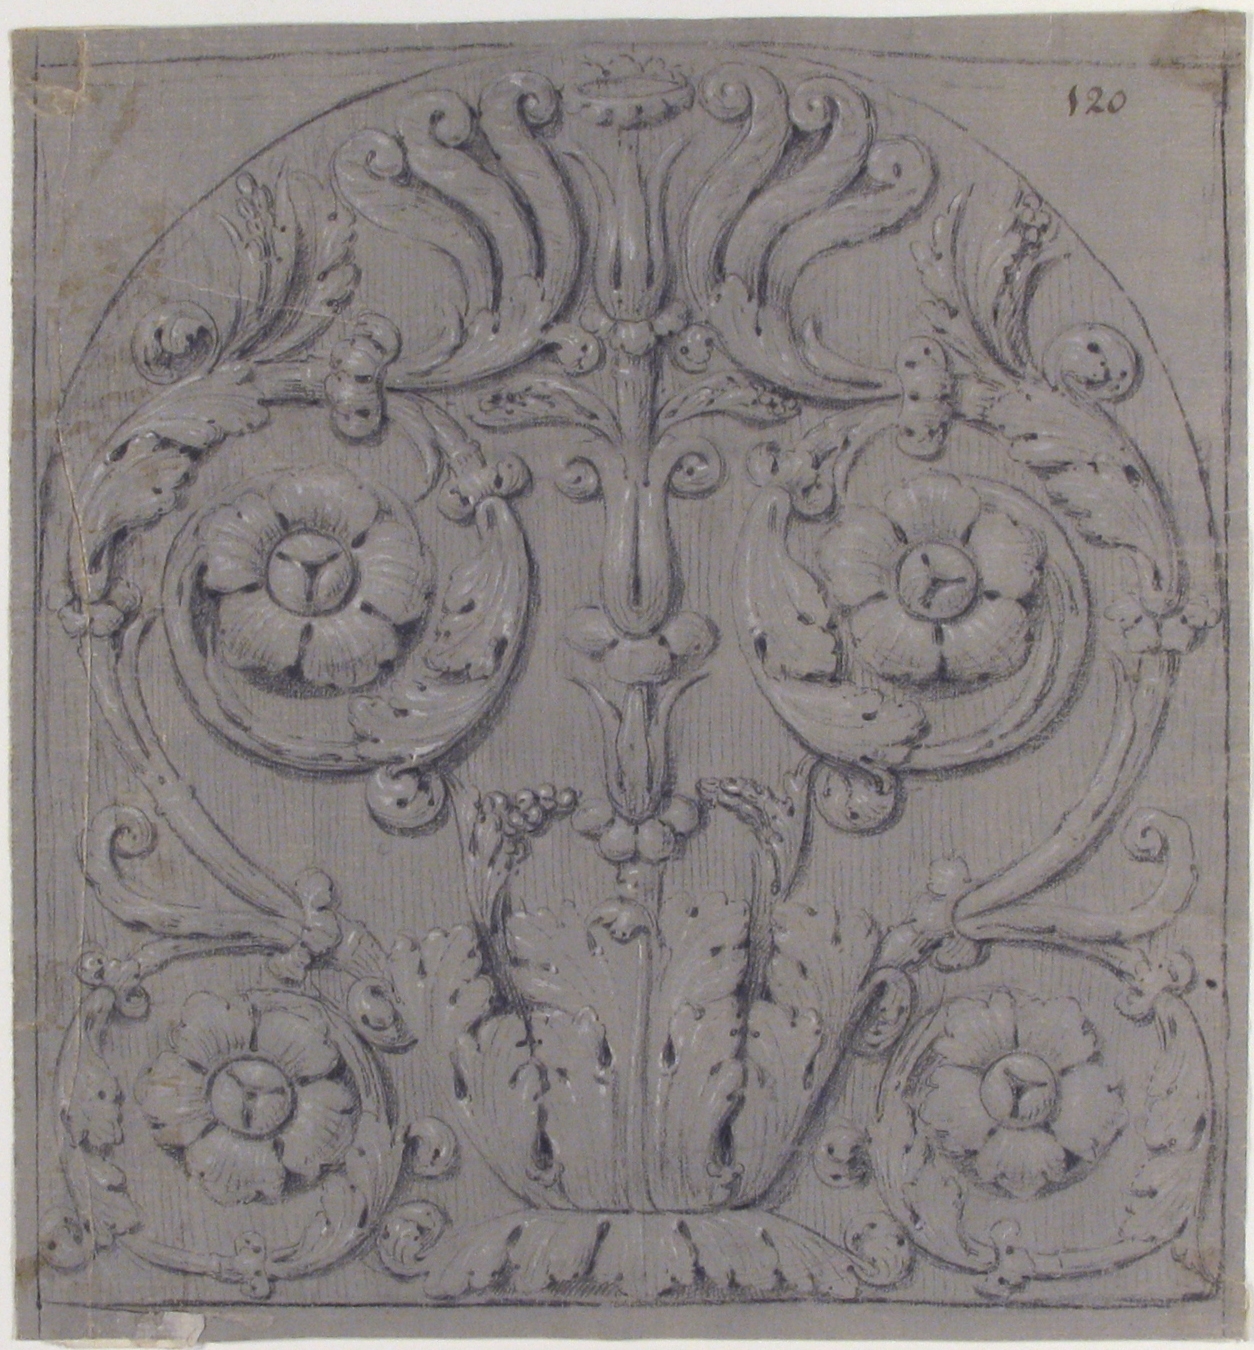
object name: drawing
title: Design for Sculpted Ornament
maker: anonymous, french, 19th century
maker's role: artist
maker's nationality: french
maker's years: 1800-1900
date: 1825-1850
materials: chalk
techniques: heightening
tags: ornament,flowers